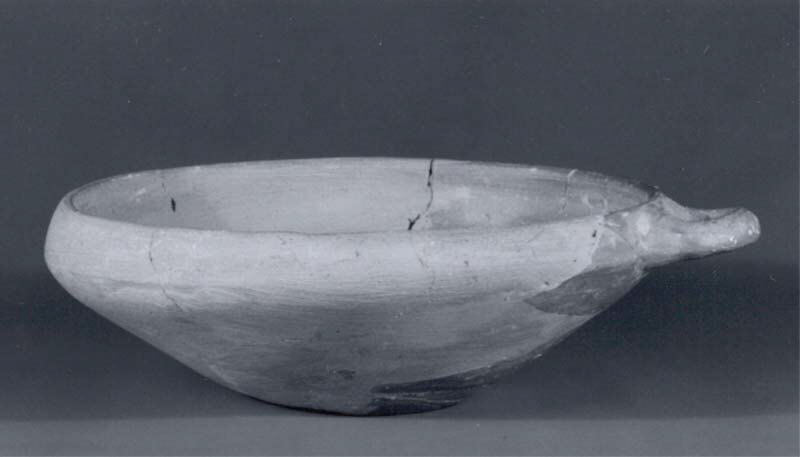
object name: bowl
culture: iranian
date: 700-501 BCE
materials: ceramic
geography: iran